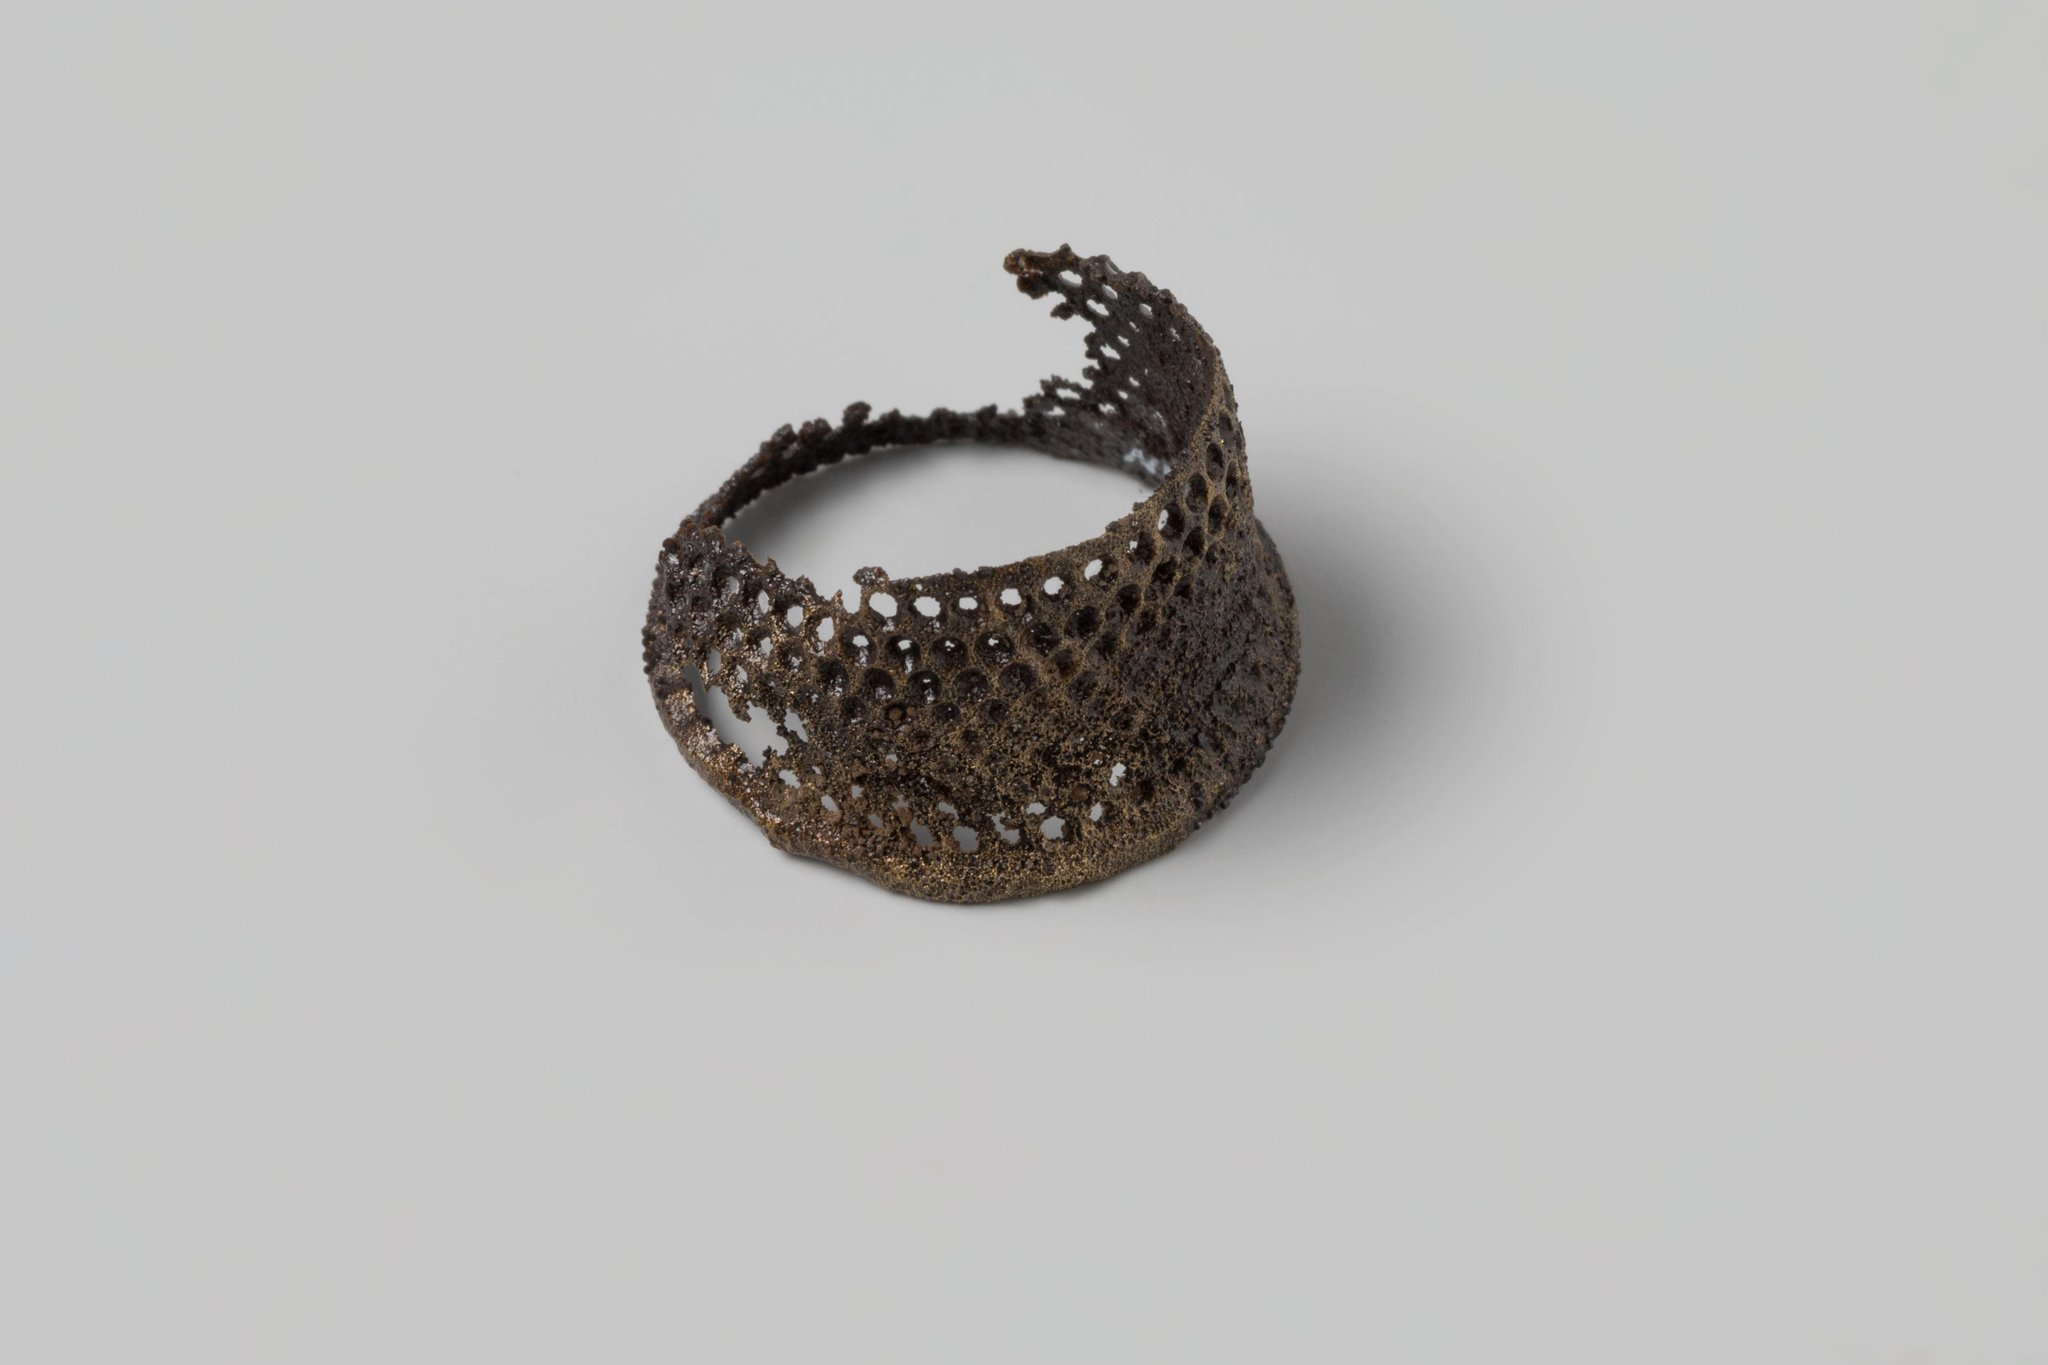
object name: thimble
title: Vingerhoed uit het wrak van de Oost-Indiëvaarder Hollandia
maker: Anonymous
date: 1700-1743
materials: copper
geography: netherlands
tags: verenigde oostindische compagnie, hollandia (schip), annet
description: Tools and instruments, sewing and sailmaking, thimble; fragm: circular rim with fragm of body, tapering, top missing, pitted surface.